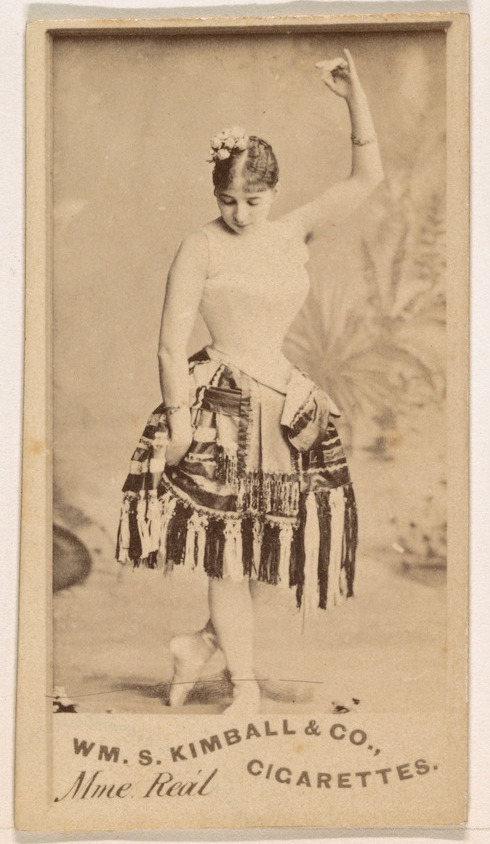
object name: photograph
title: Mme Real, from the Actresses series (N203) issued by Wm. S. Kimball & Co.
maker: william s. kimball & company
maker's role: publisher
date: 1889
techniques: color lithograph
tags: portraits,women,actresses